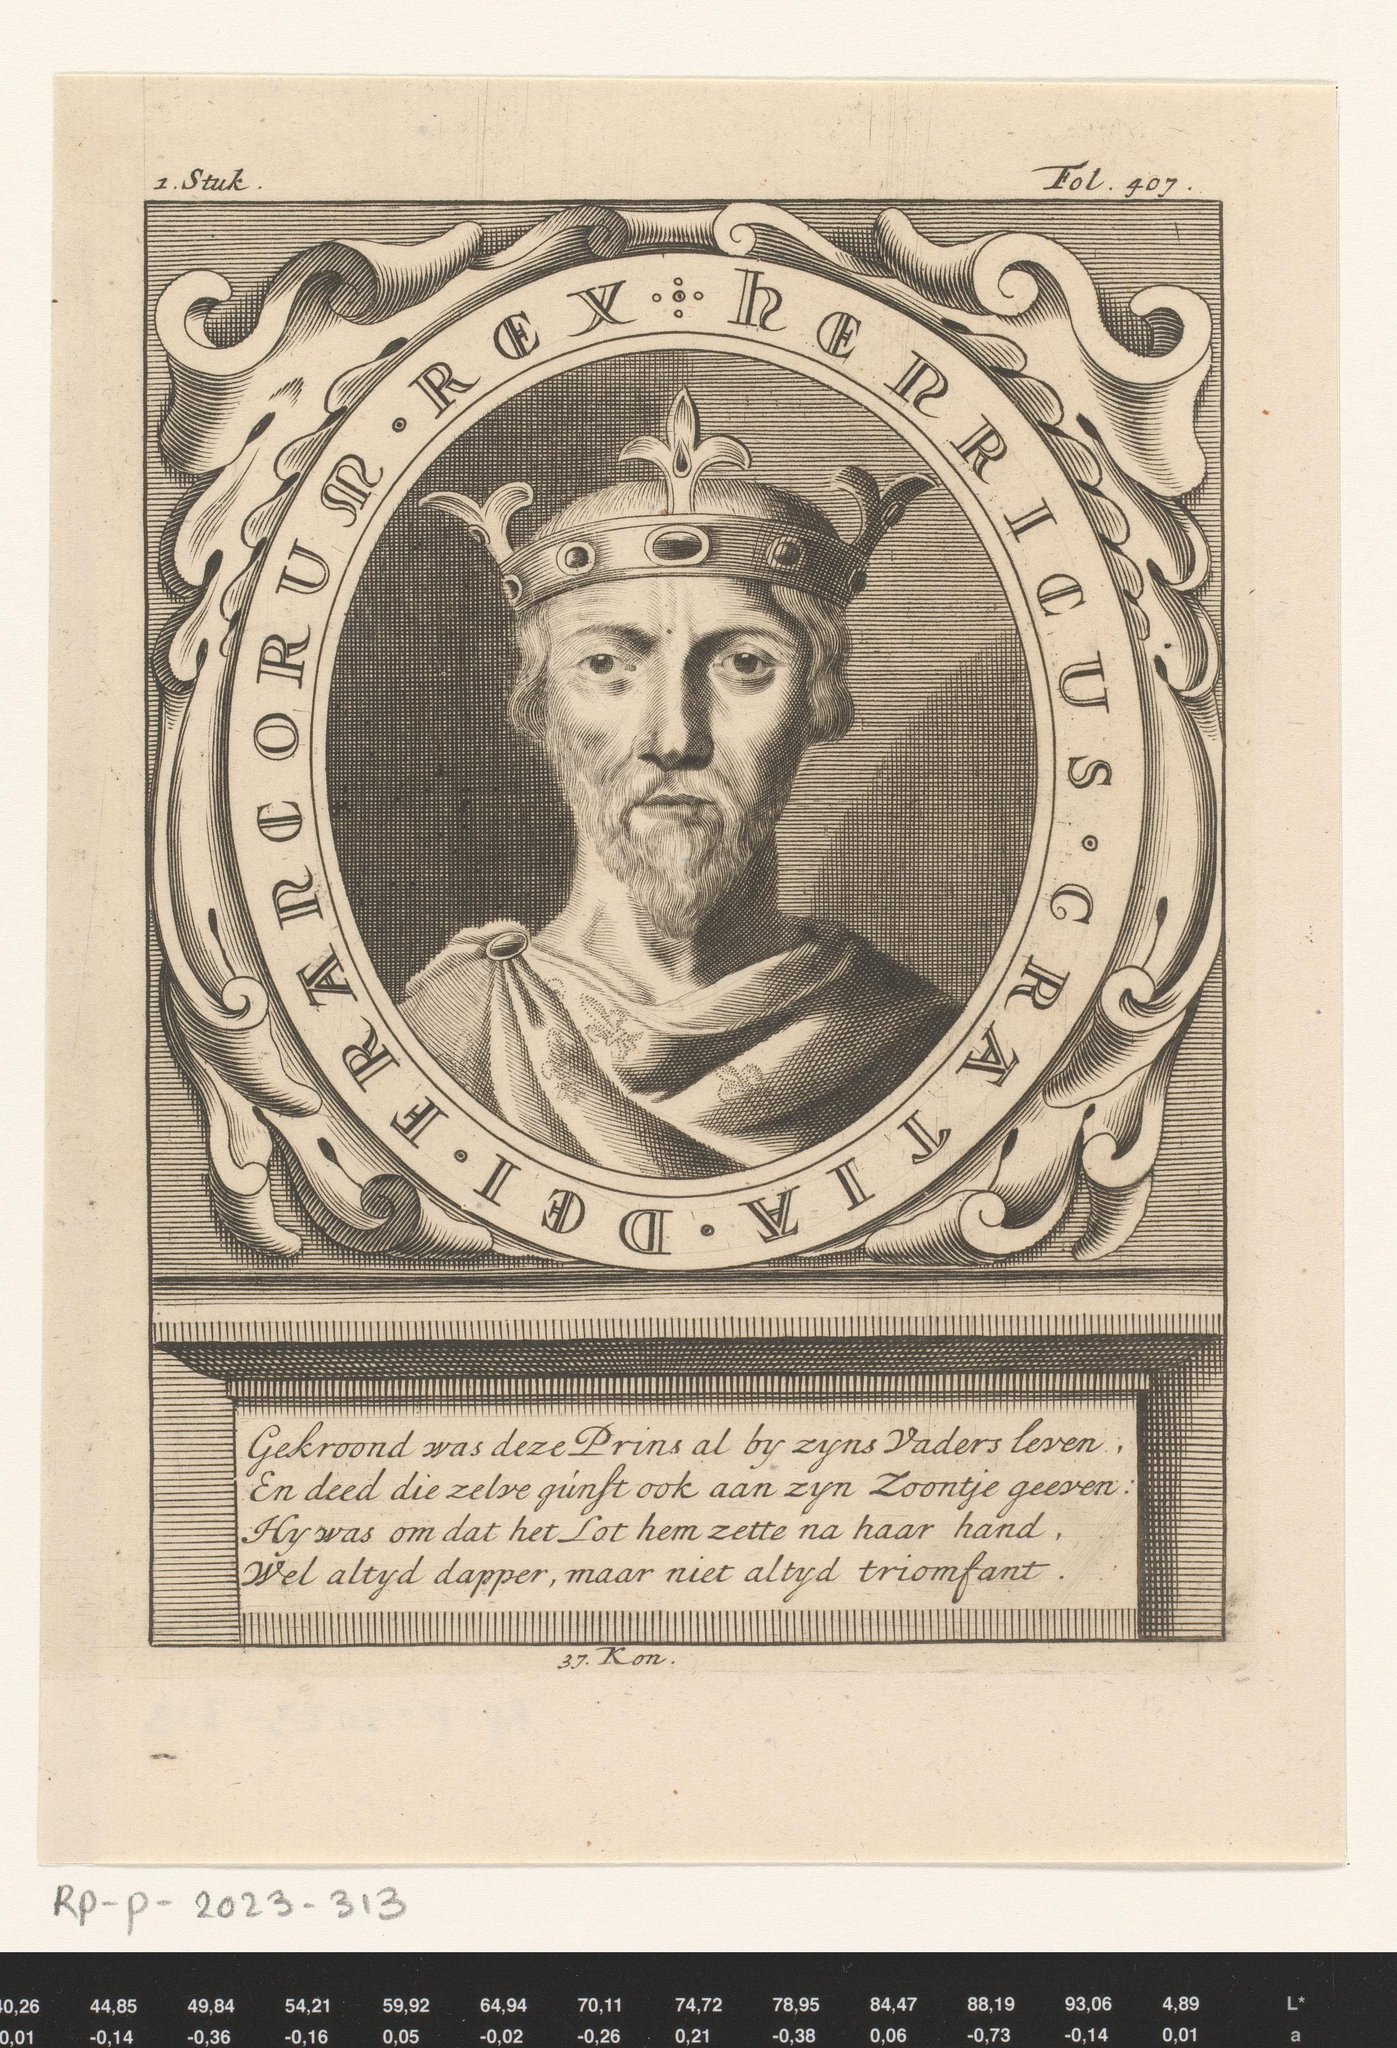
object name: print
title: Portret van Hendrik I van Frankrijk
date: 1685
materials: paper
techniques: engraving, etching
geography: amsterdam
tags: historical persons, king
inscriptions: collector's mark: Lugt 2228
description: Prent uit: Mézeray, François Eudes de. Chronyk van Vrankryk. [Vertaald uit het Frans door] G. v. Broekhuizen. Amsterdam: Timotheus ten Hoorn en Jan Bouman, 1685, dl. 1, p. 407.